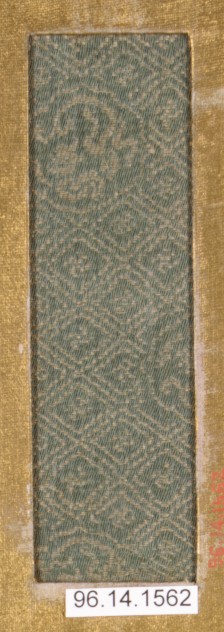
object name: piece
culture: japanese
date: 1701-1900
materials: silk